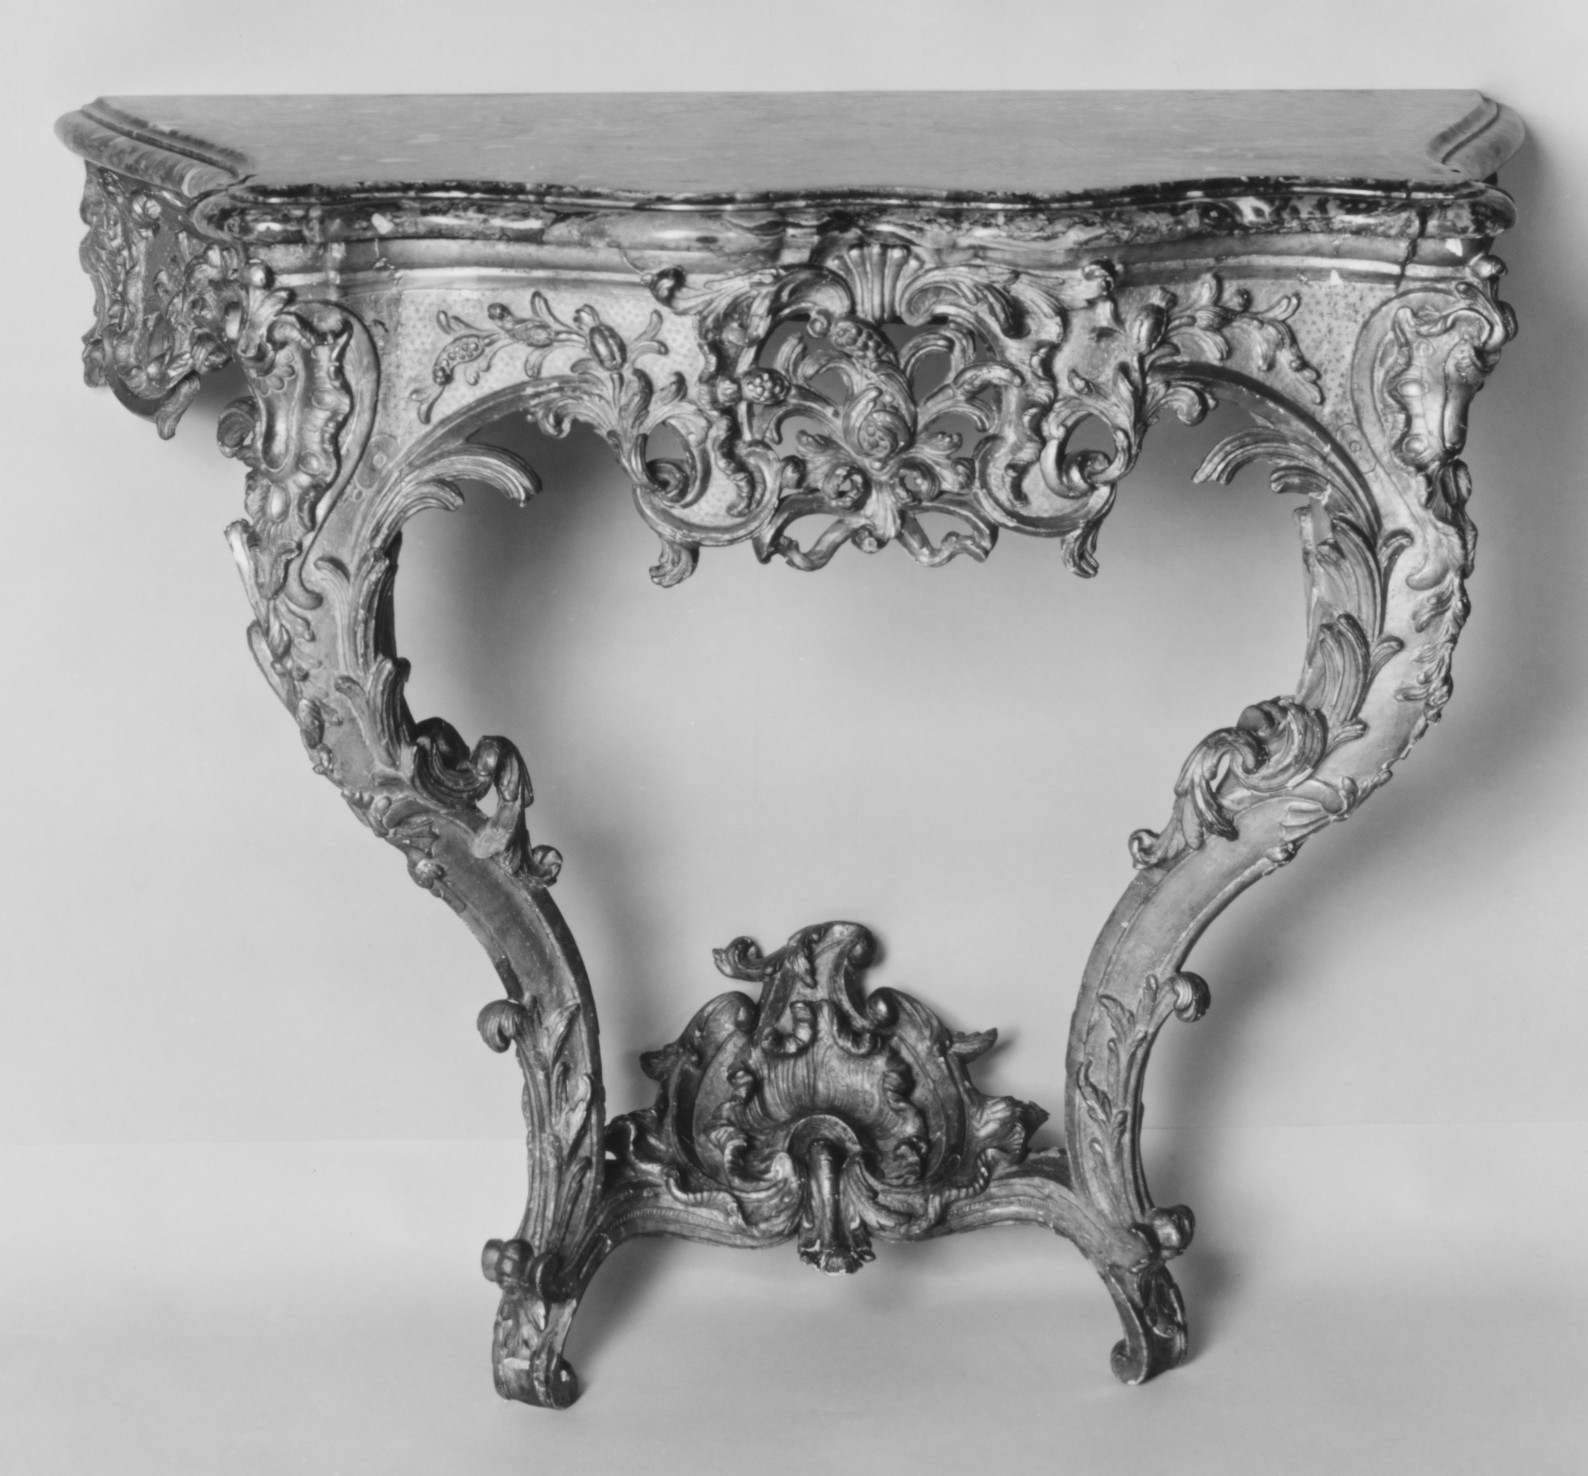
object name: console table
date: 1734-1766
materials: marble, wood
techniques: carving, gilding